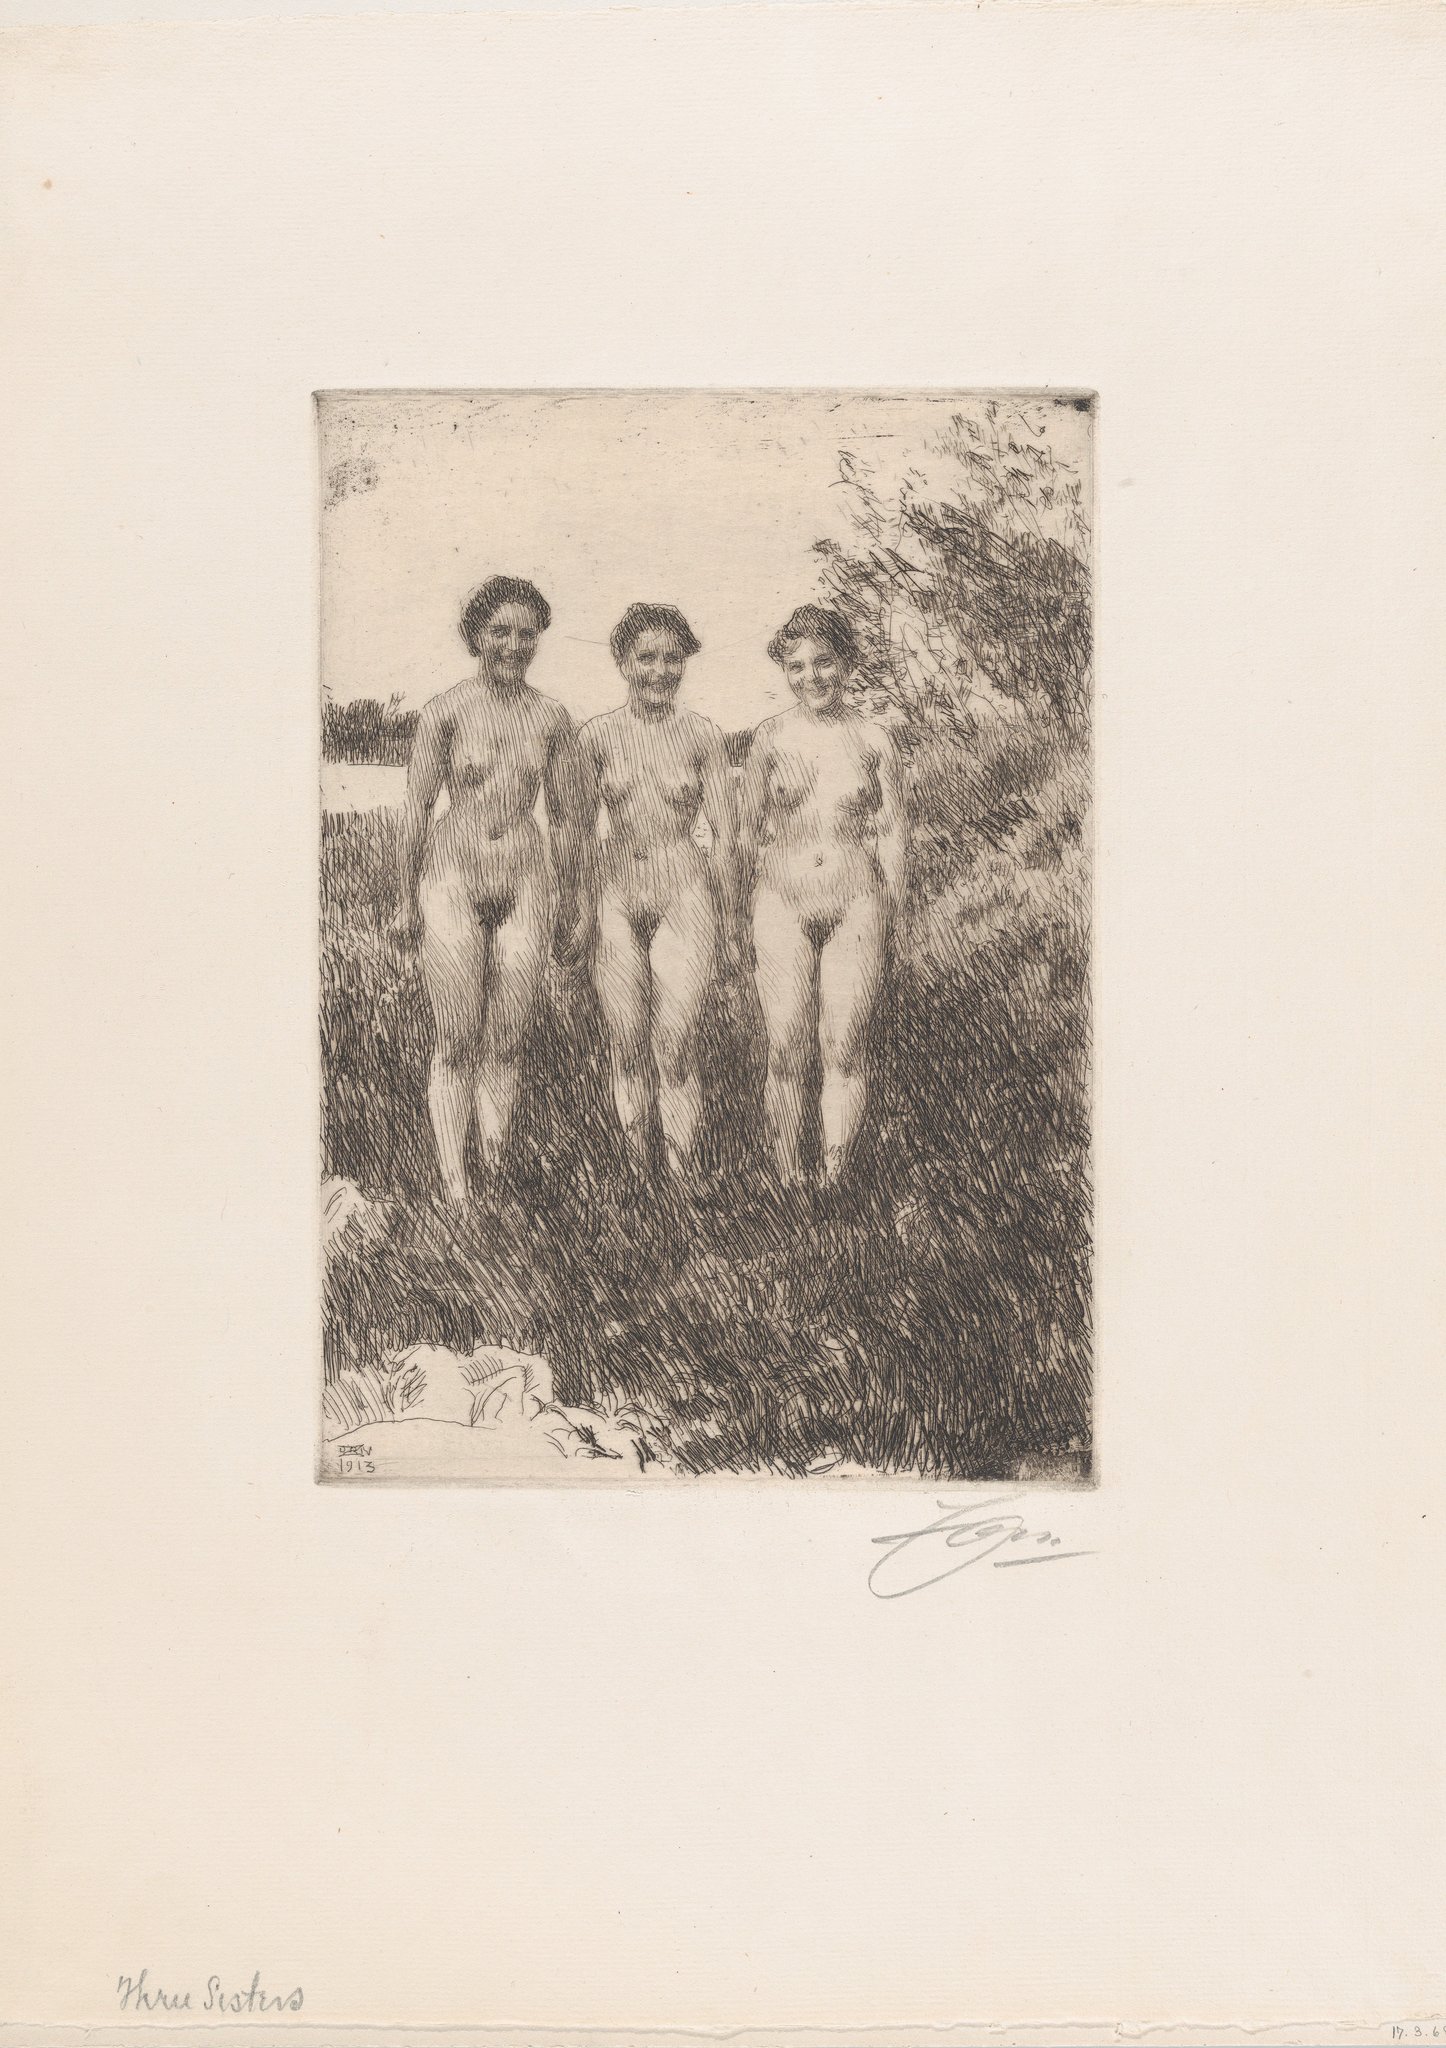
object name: print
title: Three Sisters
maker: anders zorn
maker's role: artist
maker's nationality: swedish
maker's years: 1860-1920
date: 1913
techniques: etching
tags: female nudes